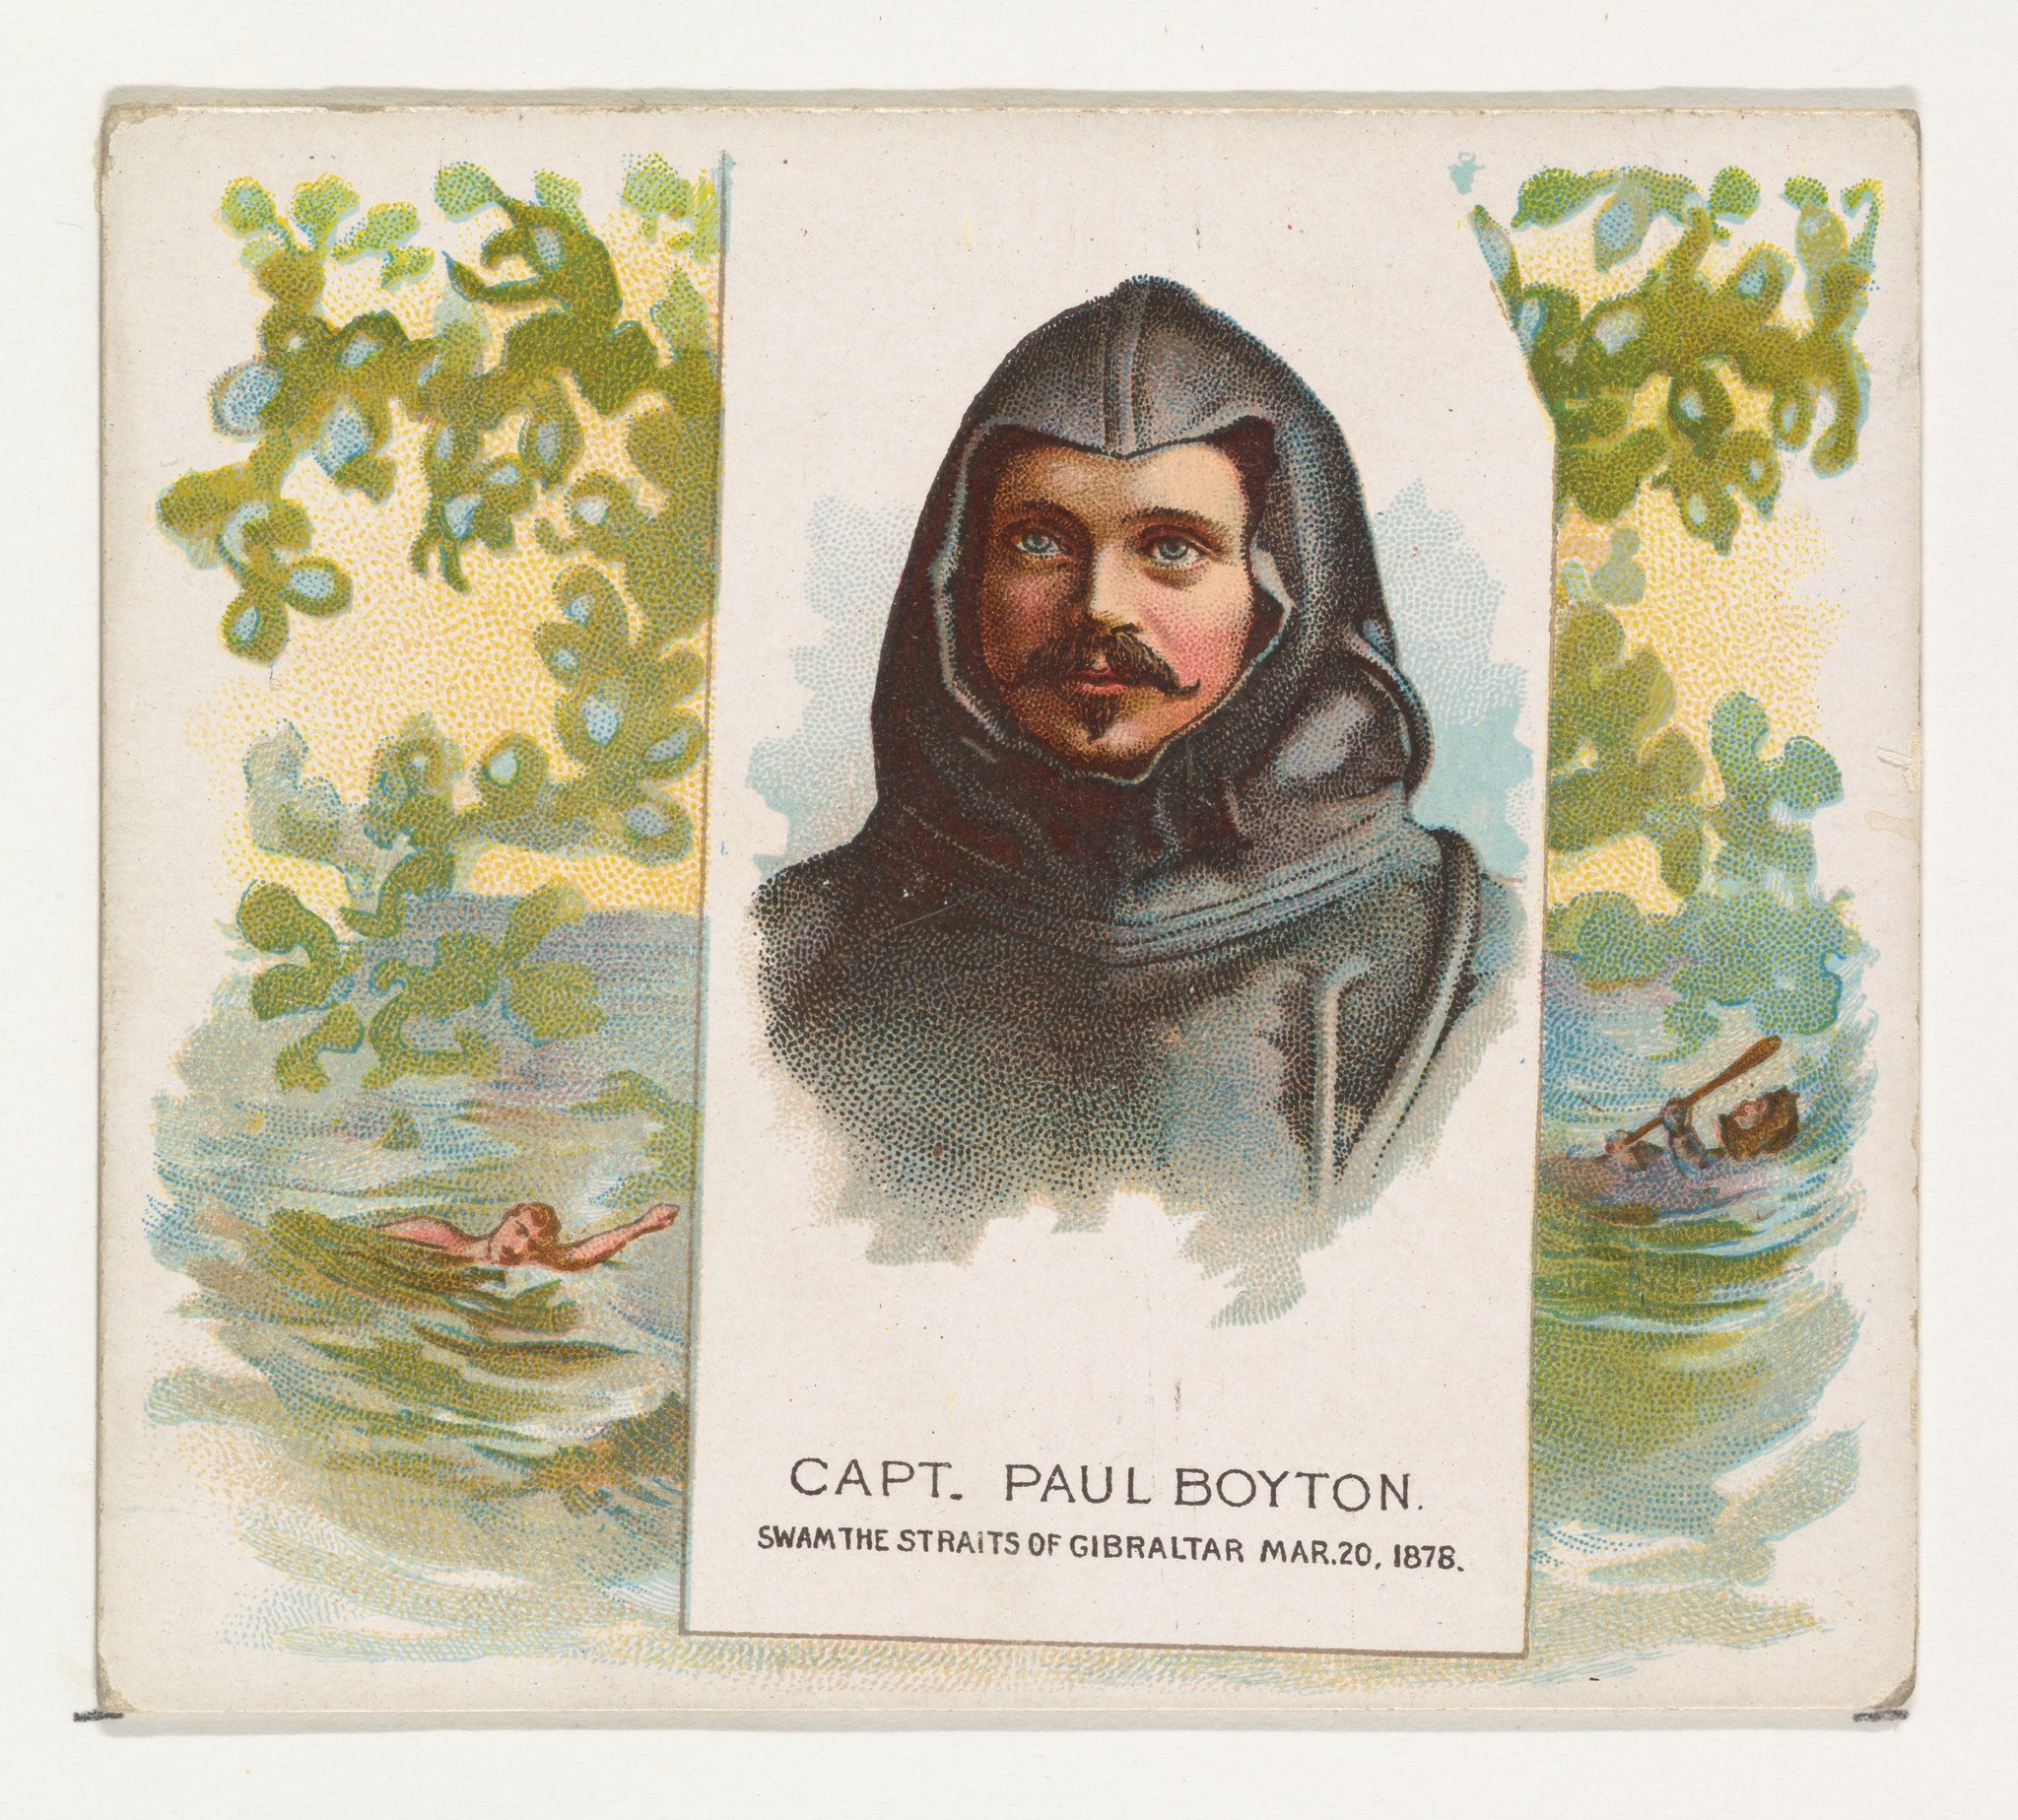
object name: print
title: Captain Paul Boyton, Swam the Straits of Gibraltar, from World's Champions, Second Series (N43) for Allen & Ginter Cigarettes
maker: allen & ginter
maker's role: publisher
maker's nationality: american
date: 1888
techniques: lithography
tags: men,athletes